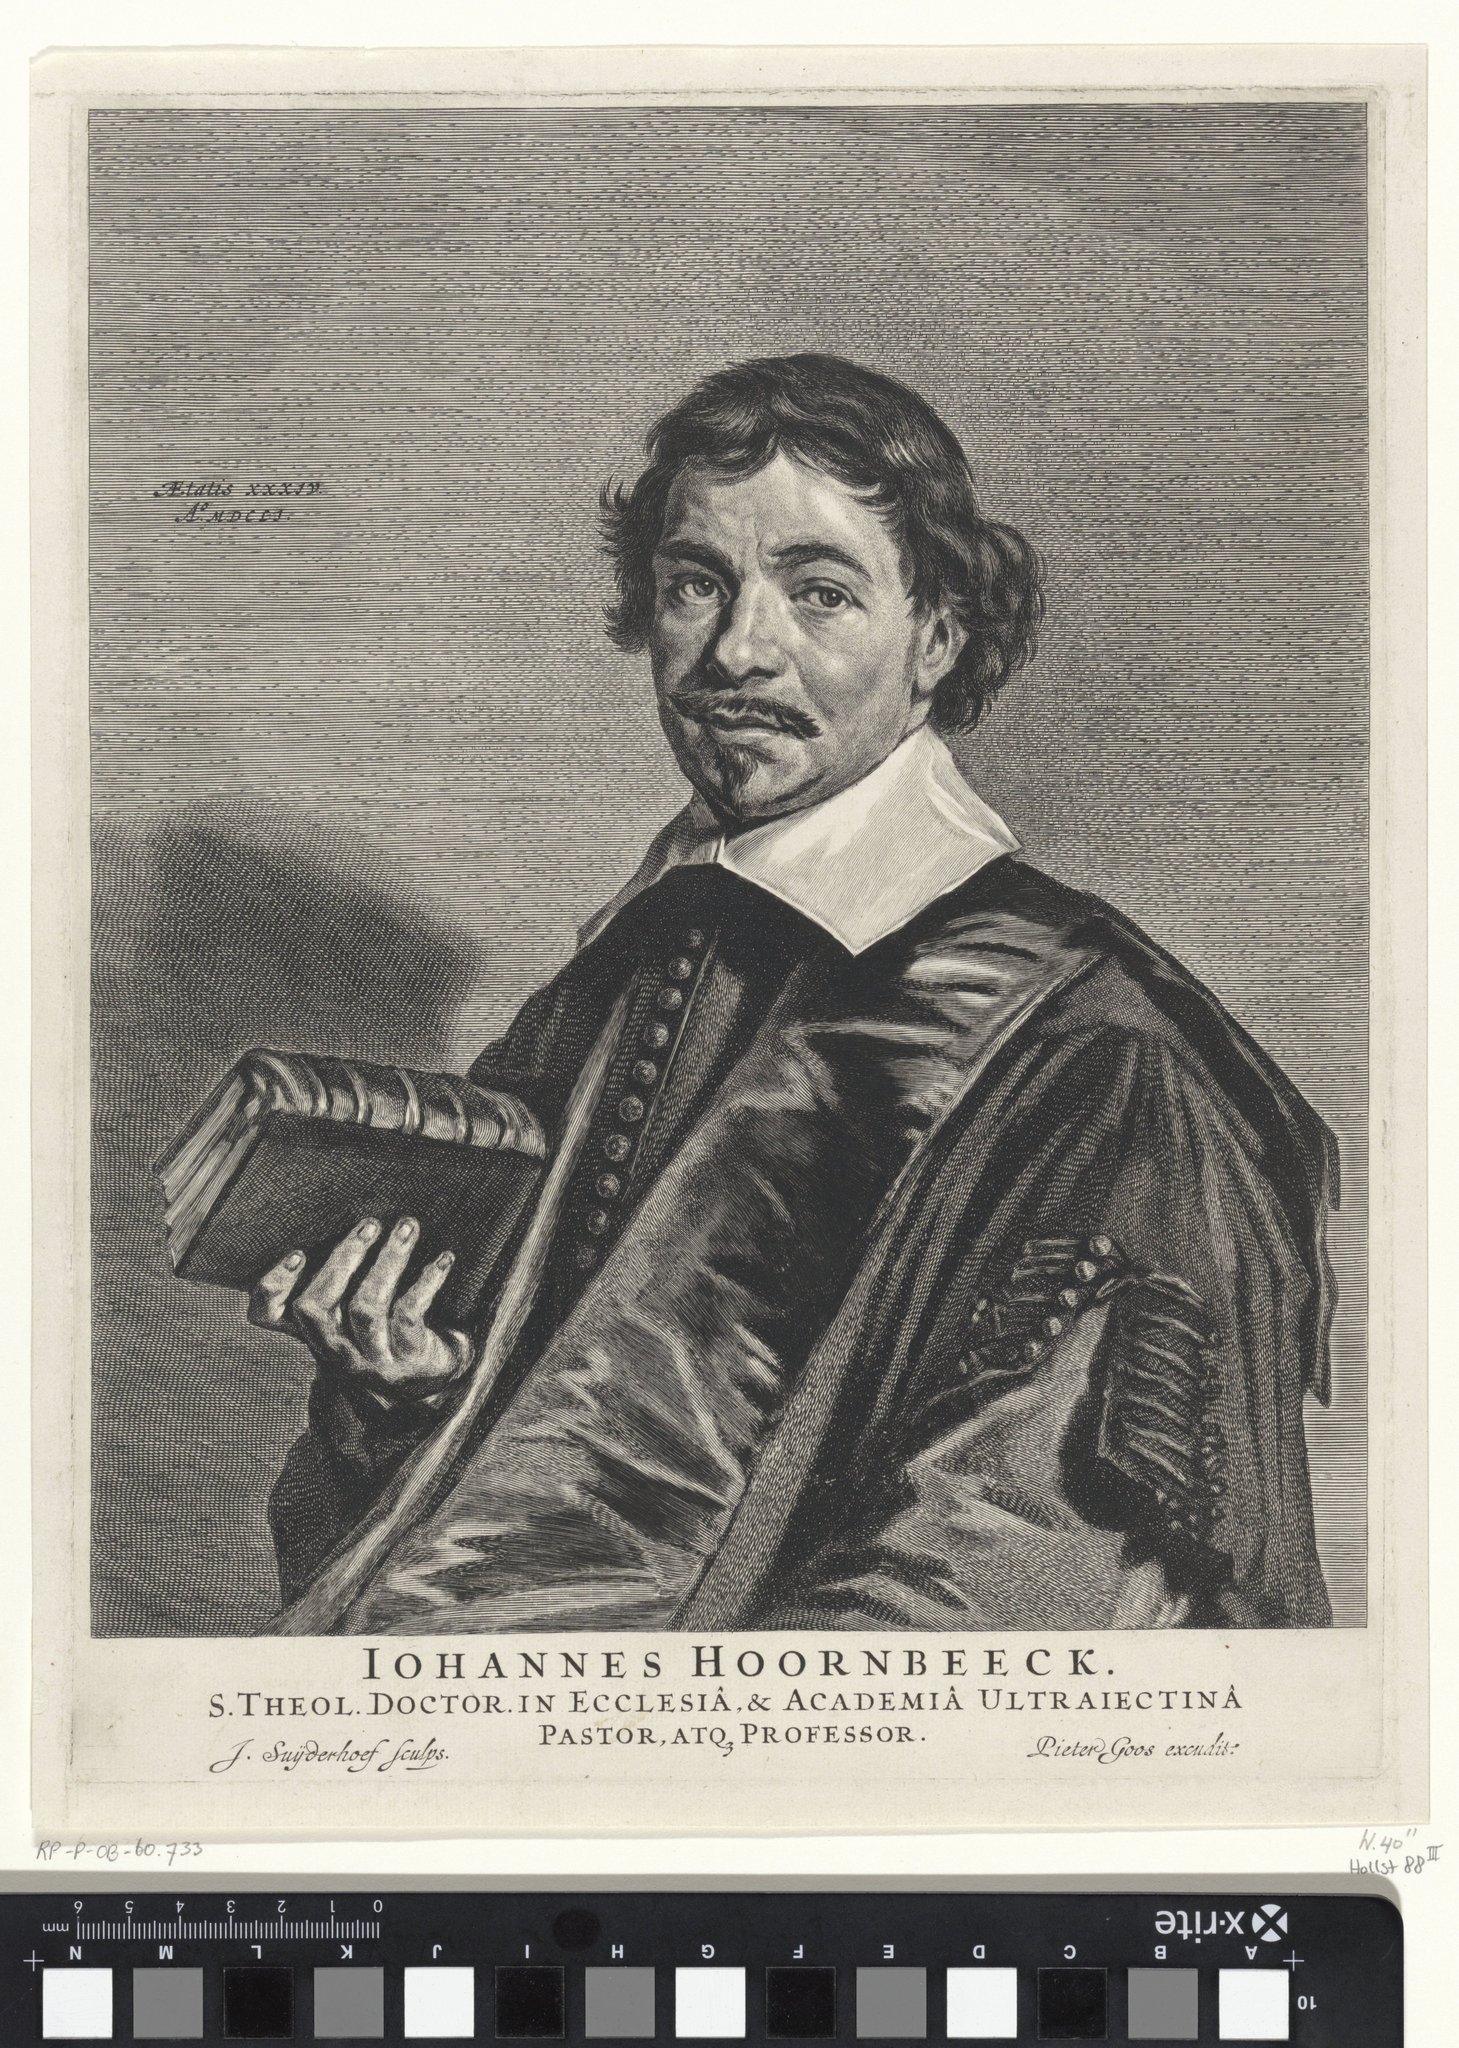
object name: print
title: Portret van Johannes Hoornbeeck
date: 1651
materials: paper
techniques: engraving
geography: amsterdam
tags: haarlem, leiden, johannes hoornbeeck, professor (+ portrait of teacher, professor), functionaries and dignitaries ~ protestant churches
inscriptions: collector's mark: Lugt 240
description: Portret van Johannes Hoornbeeck, predikant en hoogleraar theologie te Leiden, op 34-jarige leeftijd met een boek in de hand. Onderaan in de marge zijn naam en functies in het Latijn.